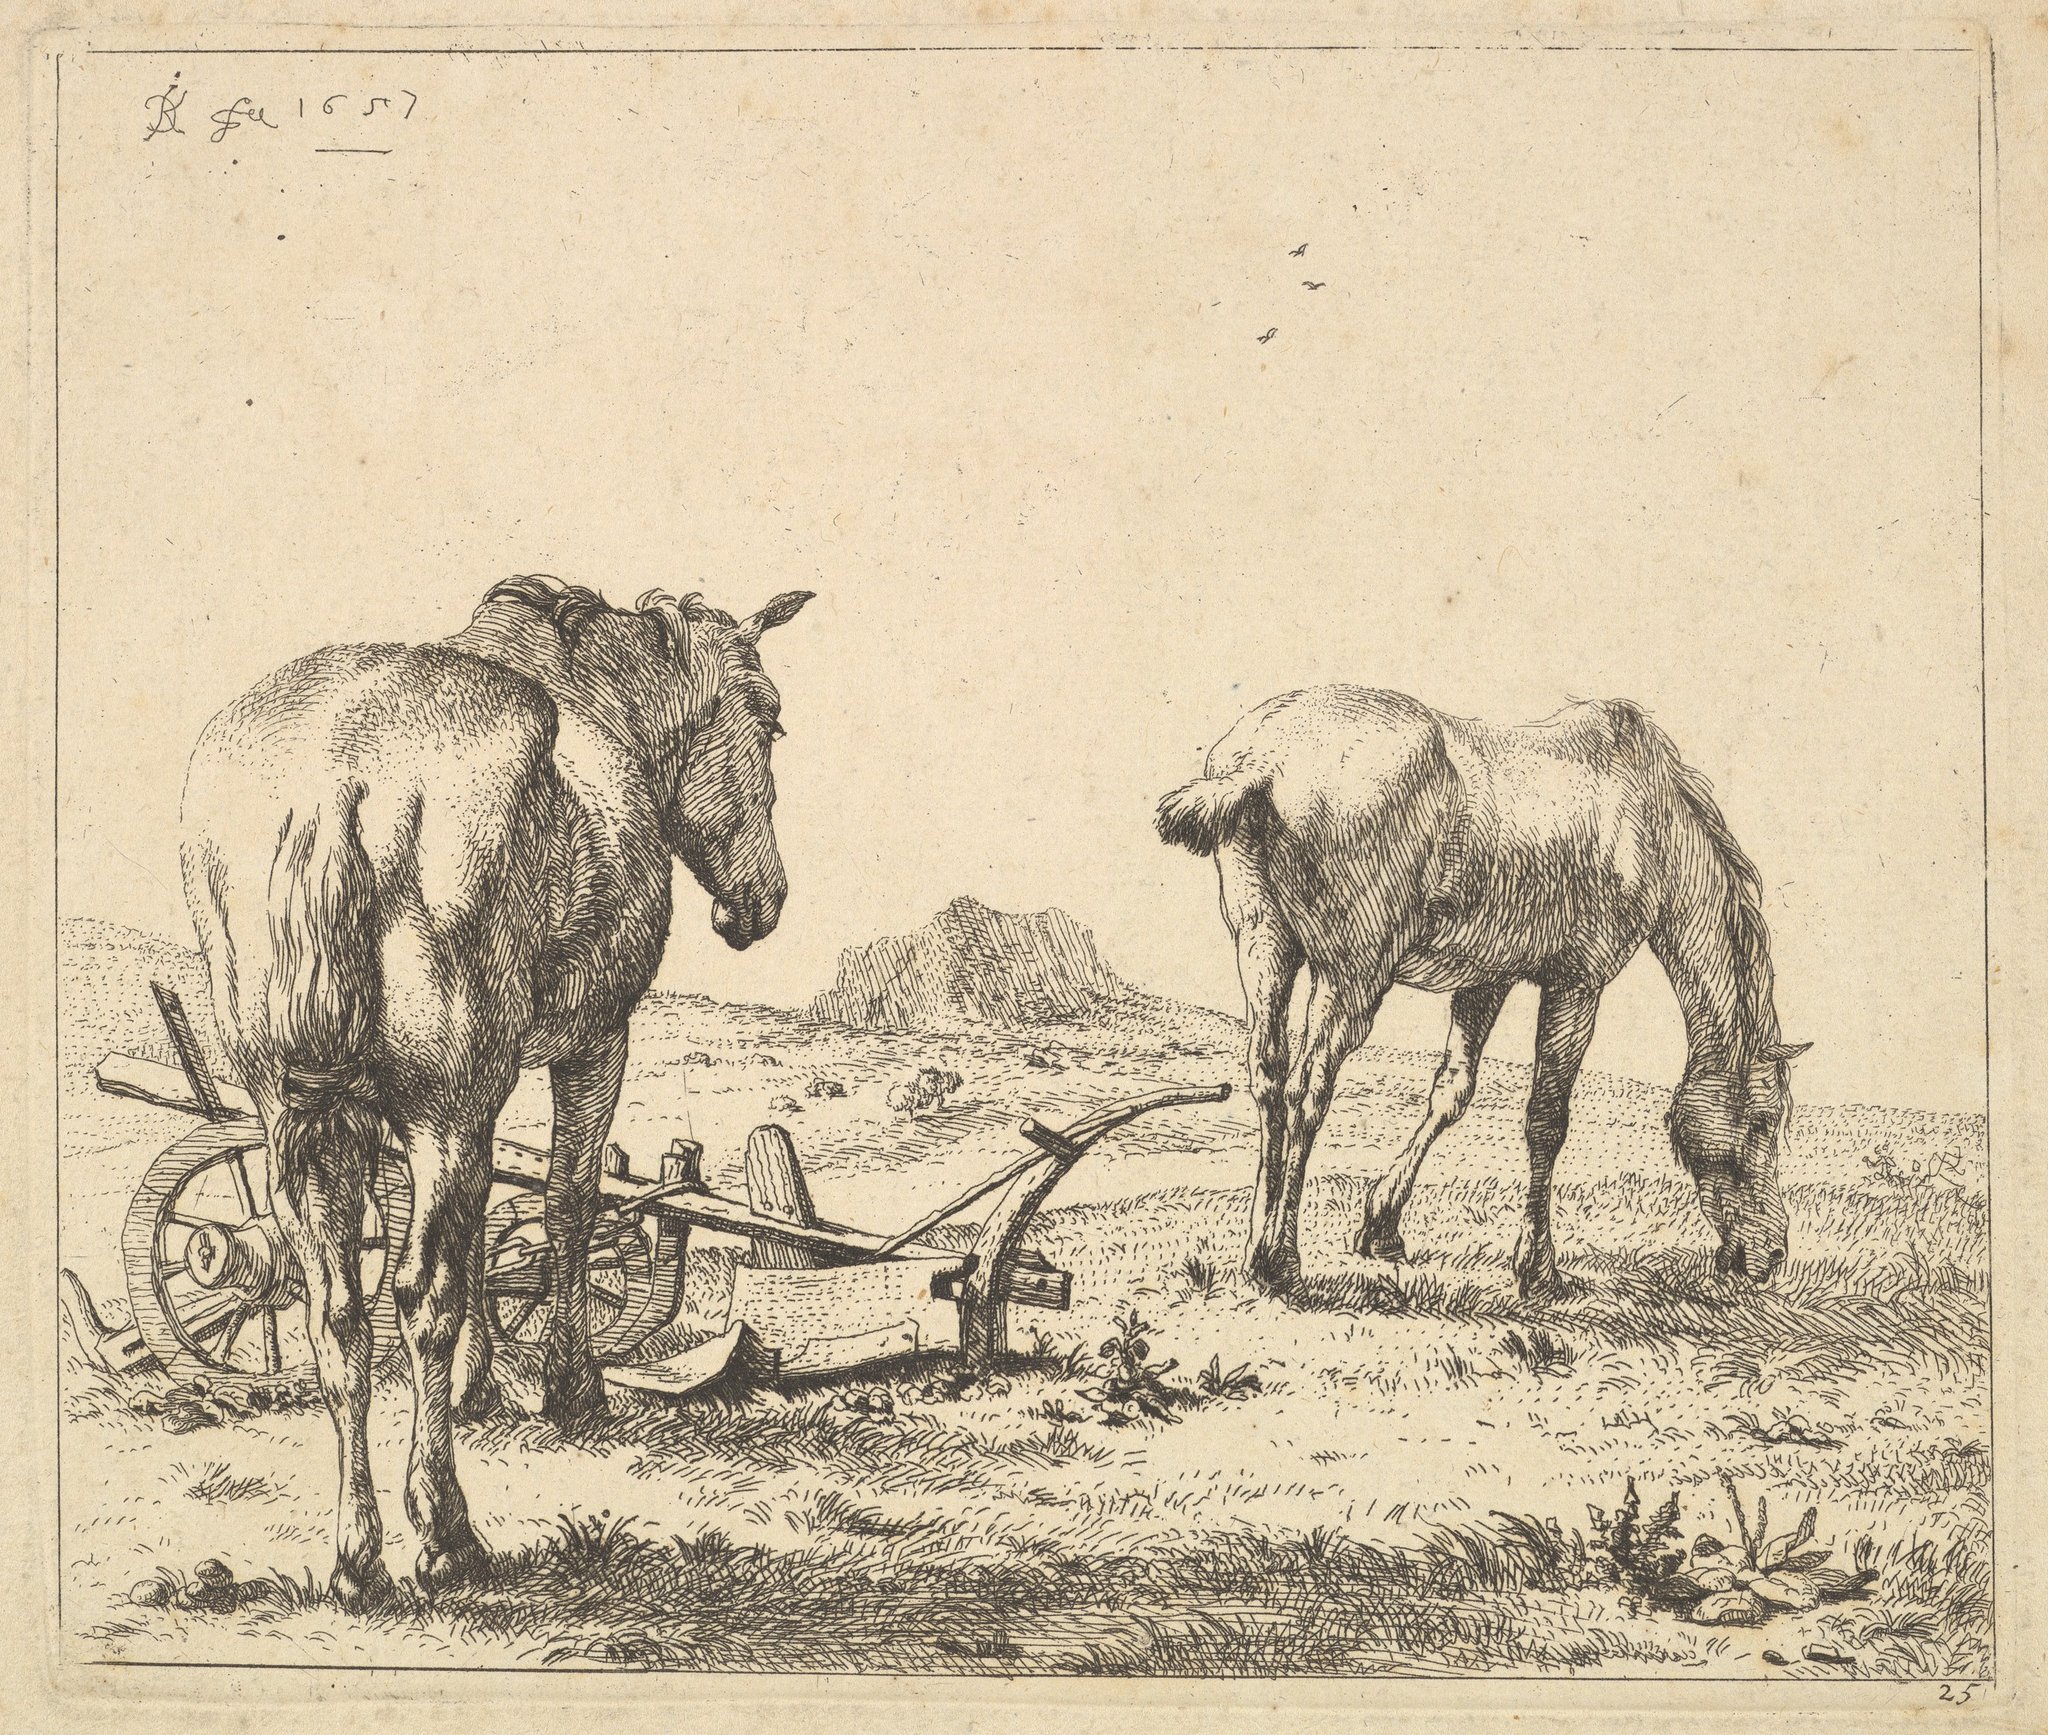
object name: print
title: Les deux chevaux près de la charrue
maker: karel dujardin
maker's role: artist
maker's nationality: dutch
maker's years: 1622-1678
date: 1657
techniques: etching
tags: horses,plows